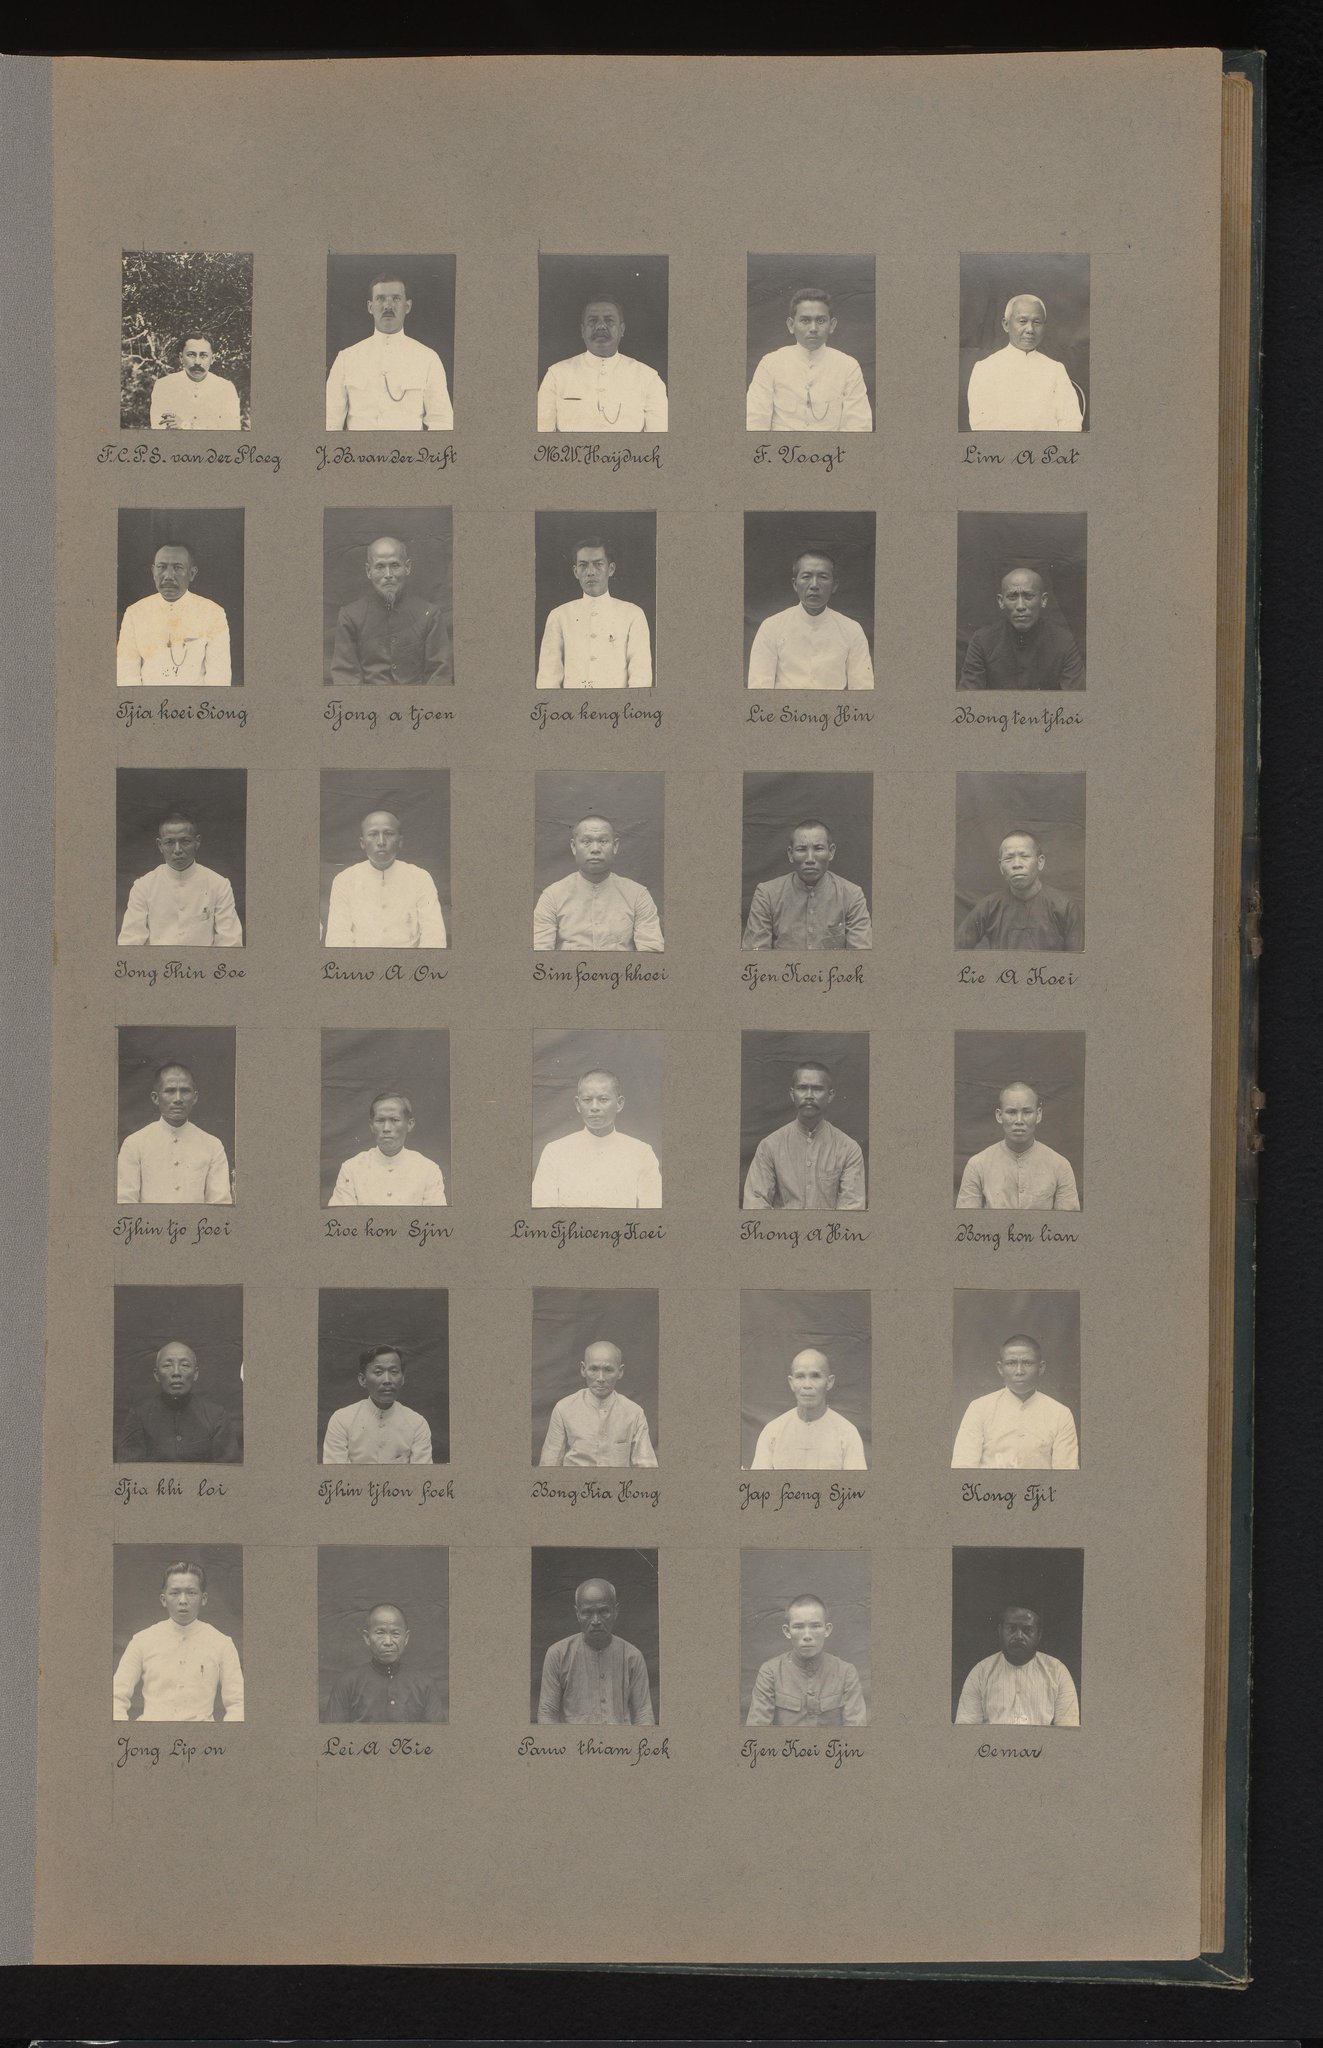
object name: album leaf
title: Pasfoto's personeel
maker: Anonymous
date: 1914-1919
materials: cardboard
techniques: gelatin silver print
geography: bangka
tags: robert julius boers, colonial system, mining, historical persons, industries ~ metal (+ men (labourers))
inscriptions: inscription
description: Albumblad met 30 kleine pasfoto's van personeel werkzaam bij het sectiebureau van de Banka-tinwinning te Muntok. Portretten van Nederlandse en Indonesische mannen, zonder aanduiding van functie. Onder de foto's de naam van de geportretteerde. Onderdeel van het fotoalbum aangeboden aan Robert Julius Boers bij zijn vertrek naar Nederland in 1919 door het personeel van de Banka-tinwinning.